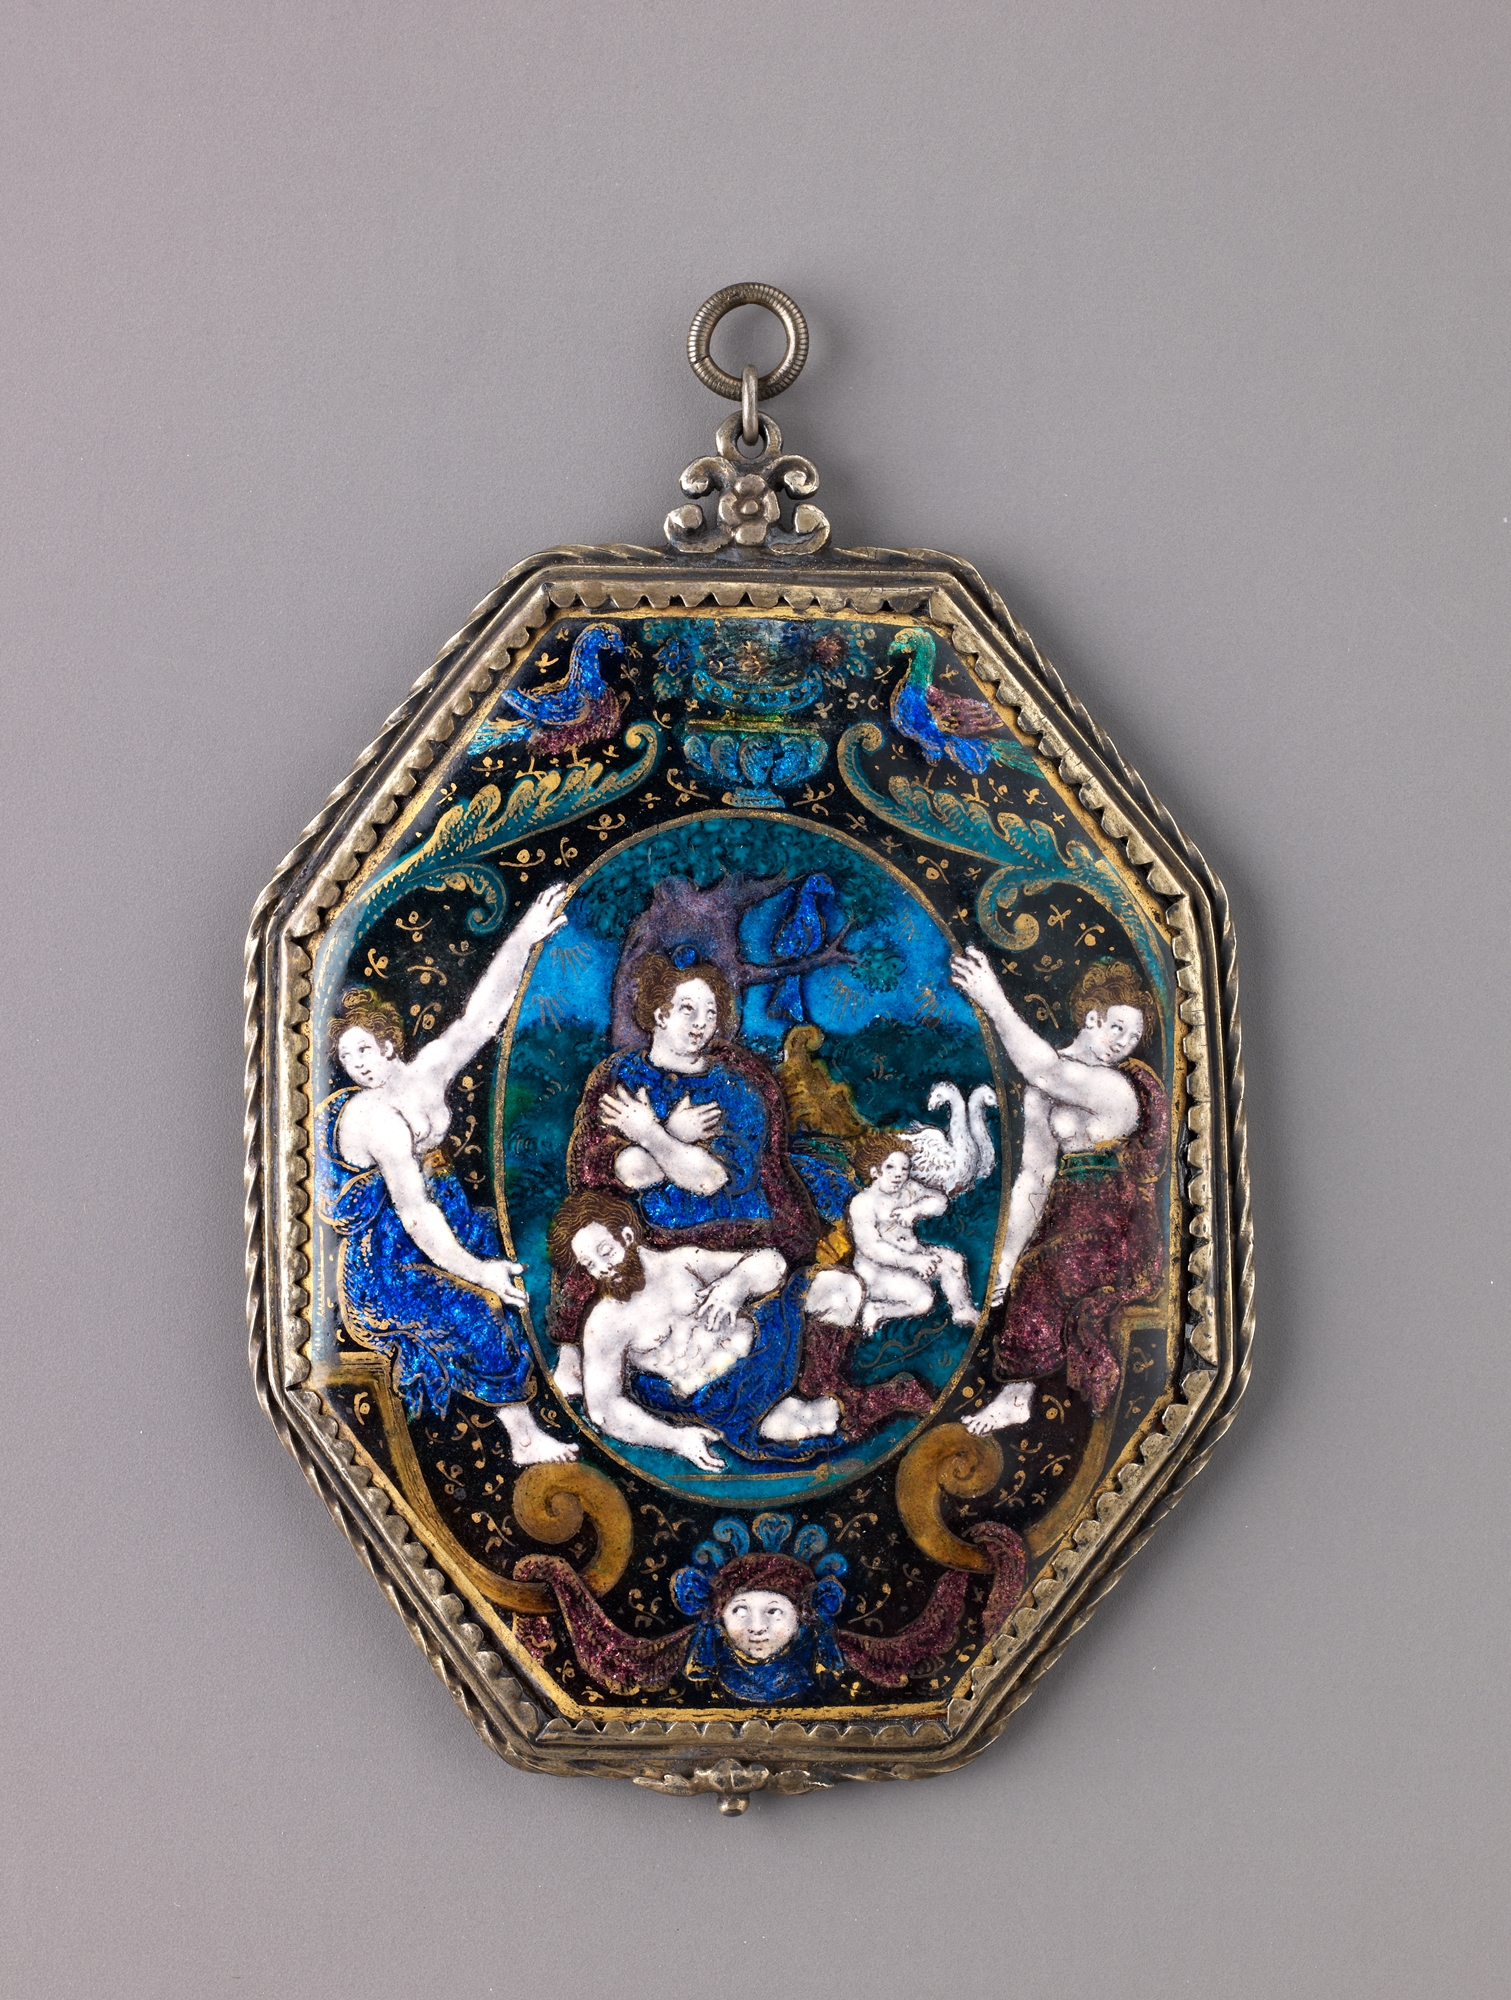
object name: mirror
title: Mirror: Venus Mourning the Dead Adonis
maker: suzanne de court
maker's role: artist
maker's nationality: french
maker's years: 1575-1625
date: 1601-1633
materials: copper, enamel, gilt, glass, silver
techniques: painting, silvered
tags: adonis,venus,swans